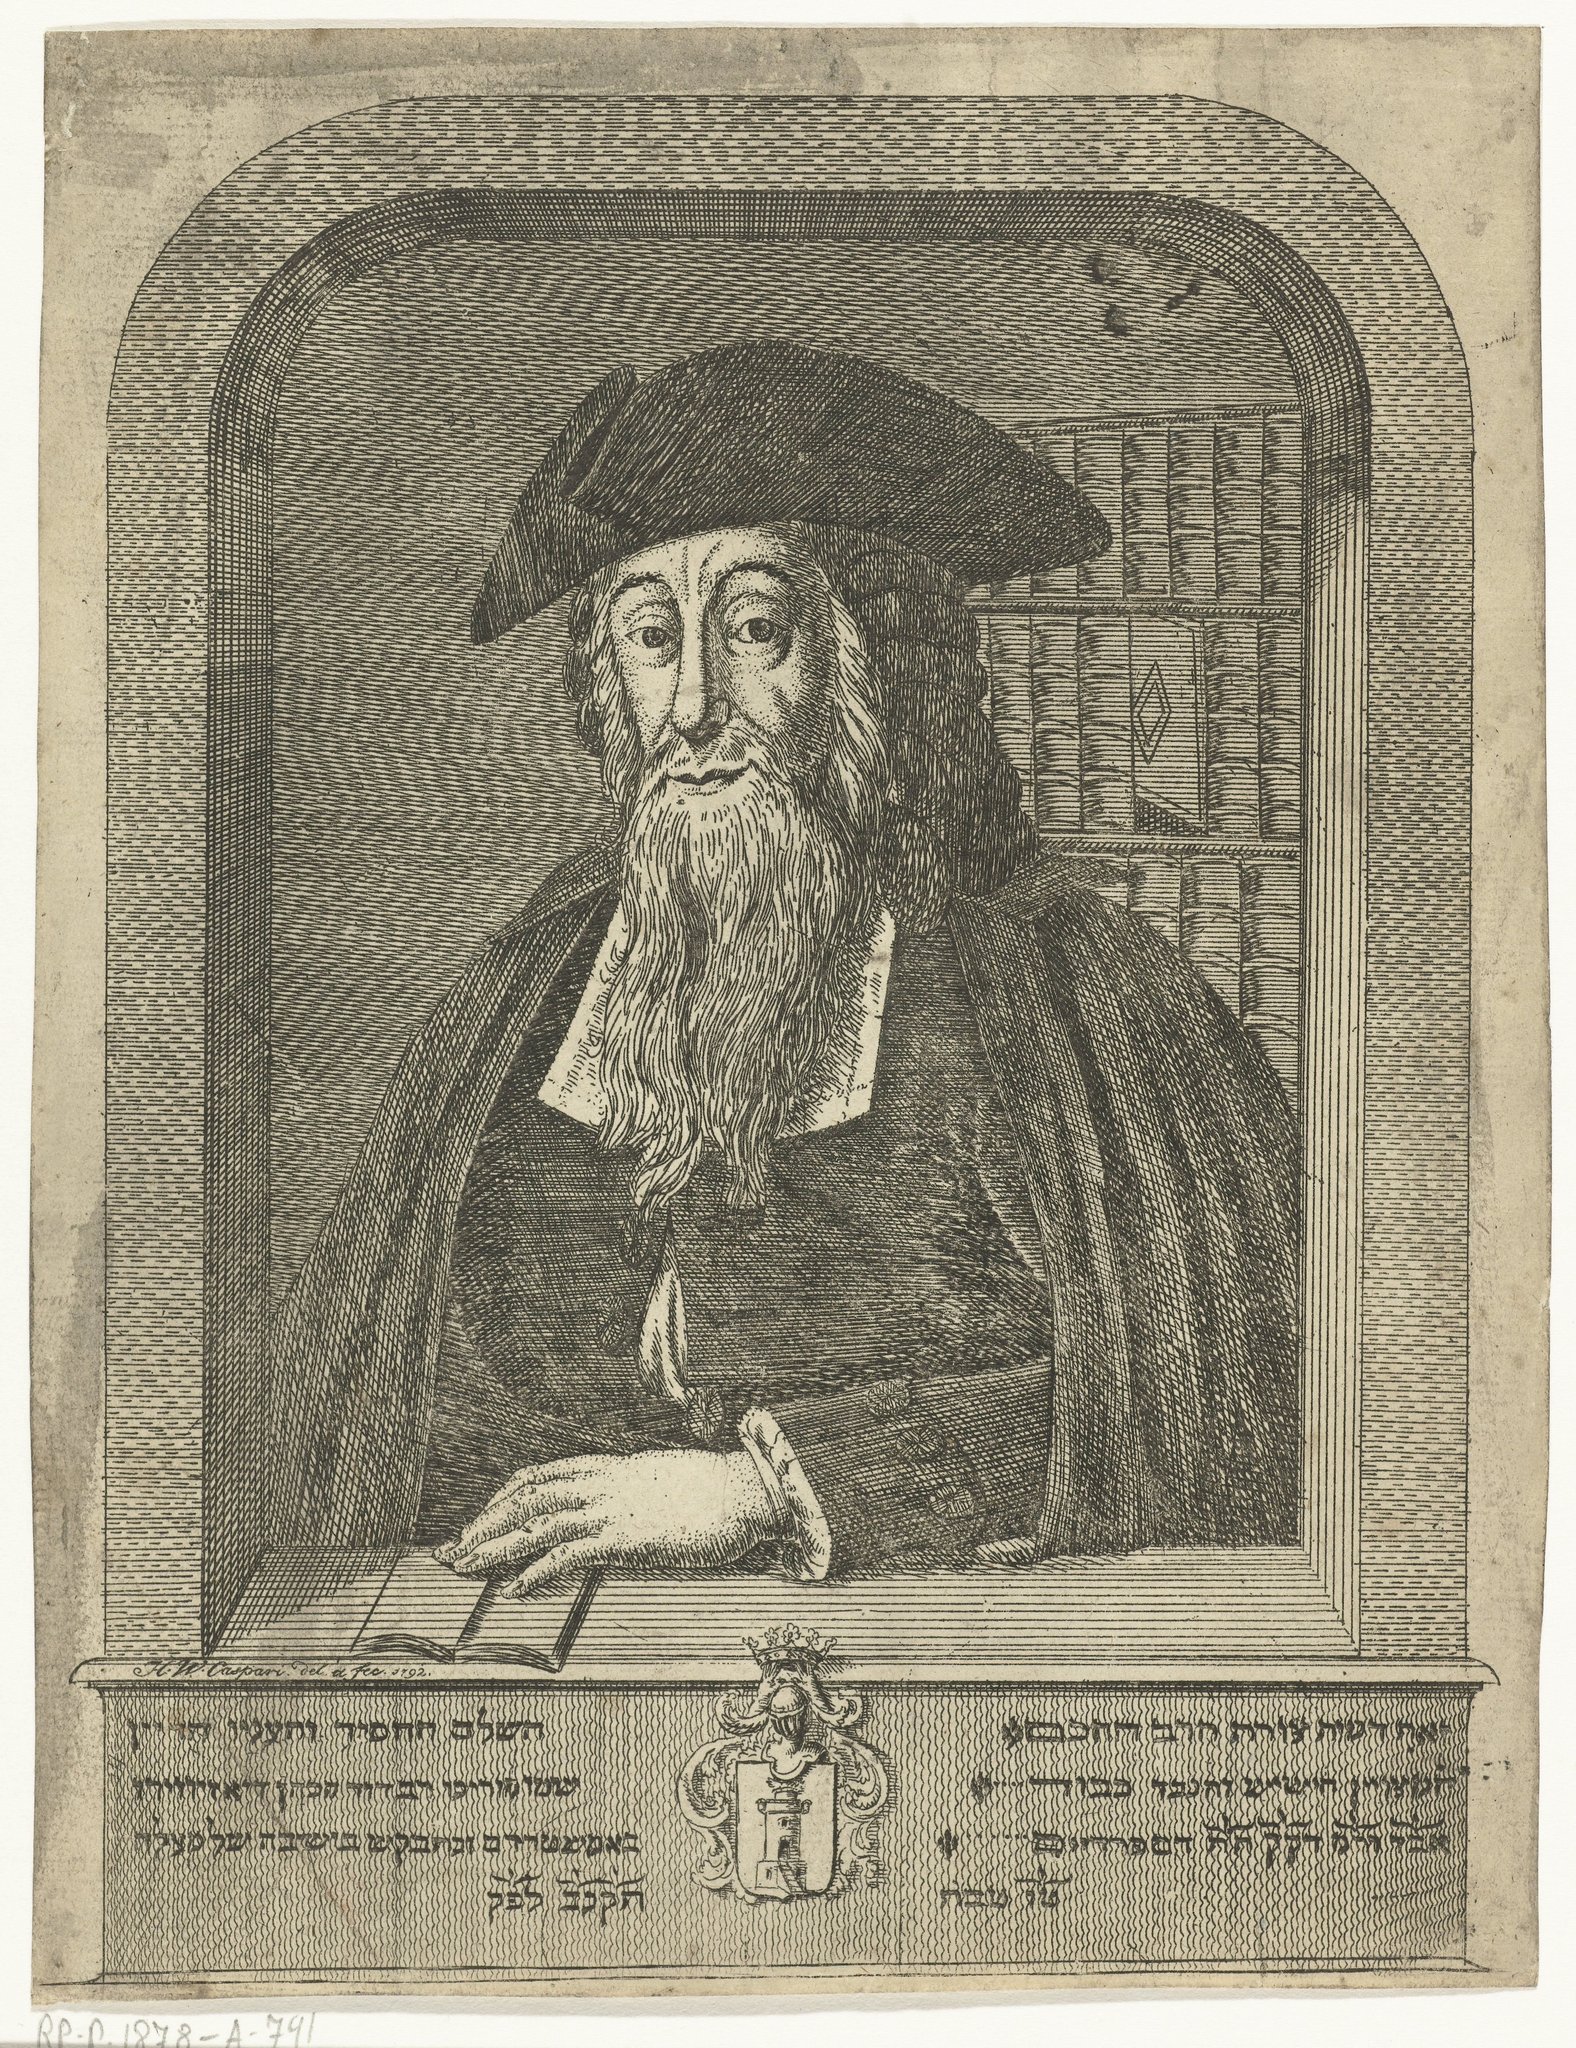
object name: print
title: Portret van David Cohen d'Azevedo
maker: hendrik willem caspari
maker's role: draughtsman, print maker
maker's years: 1770-1829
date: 1780-1829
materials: paper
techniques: etching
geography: amsterdam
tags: david cohen d'azevedo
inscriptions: collector's mark: Lugt 2228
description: Portret van van David Cohen d'Azevedo, de opperrabijn van de Portugees-joodse gemeente in Amsterdam. Buste naar links. Cohen draagt een steek op het hoofd en leest een boek. In de achtergrond een boekenkast.